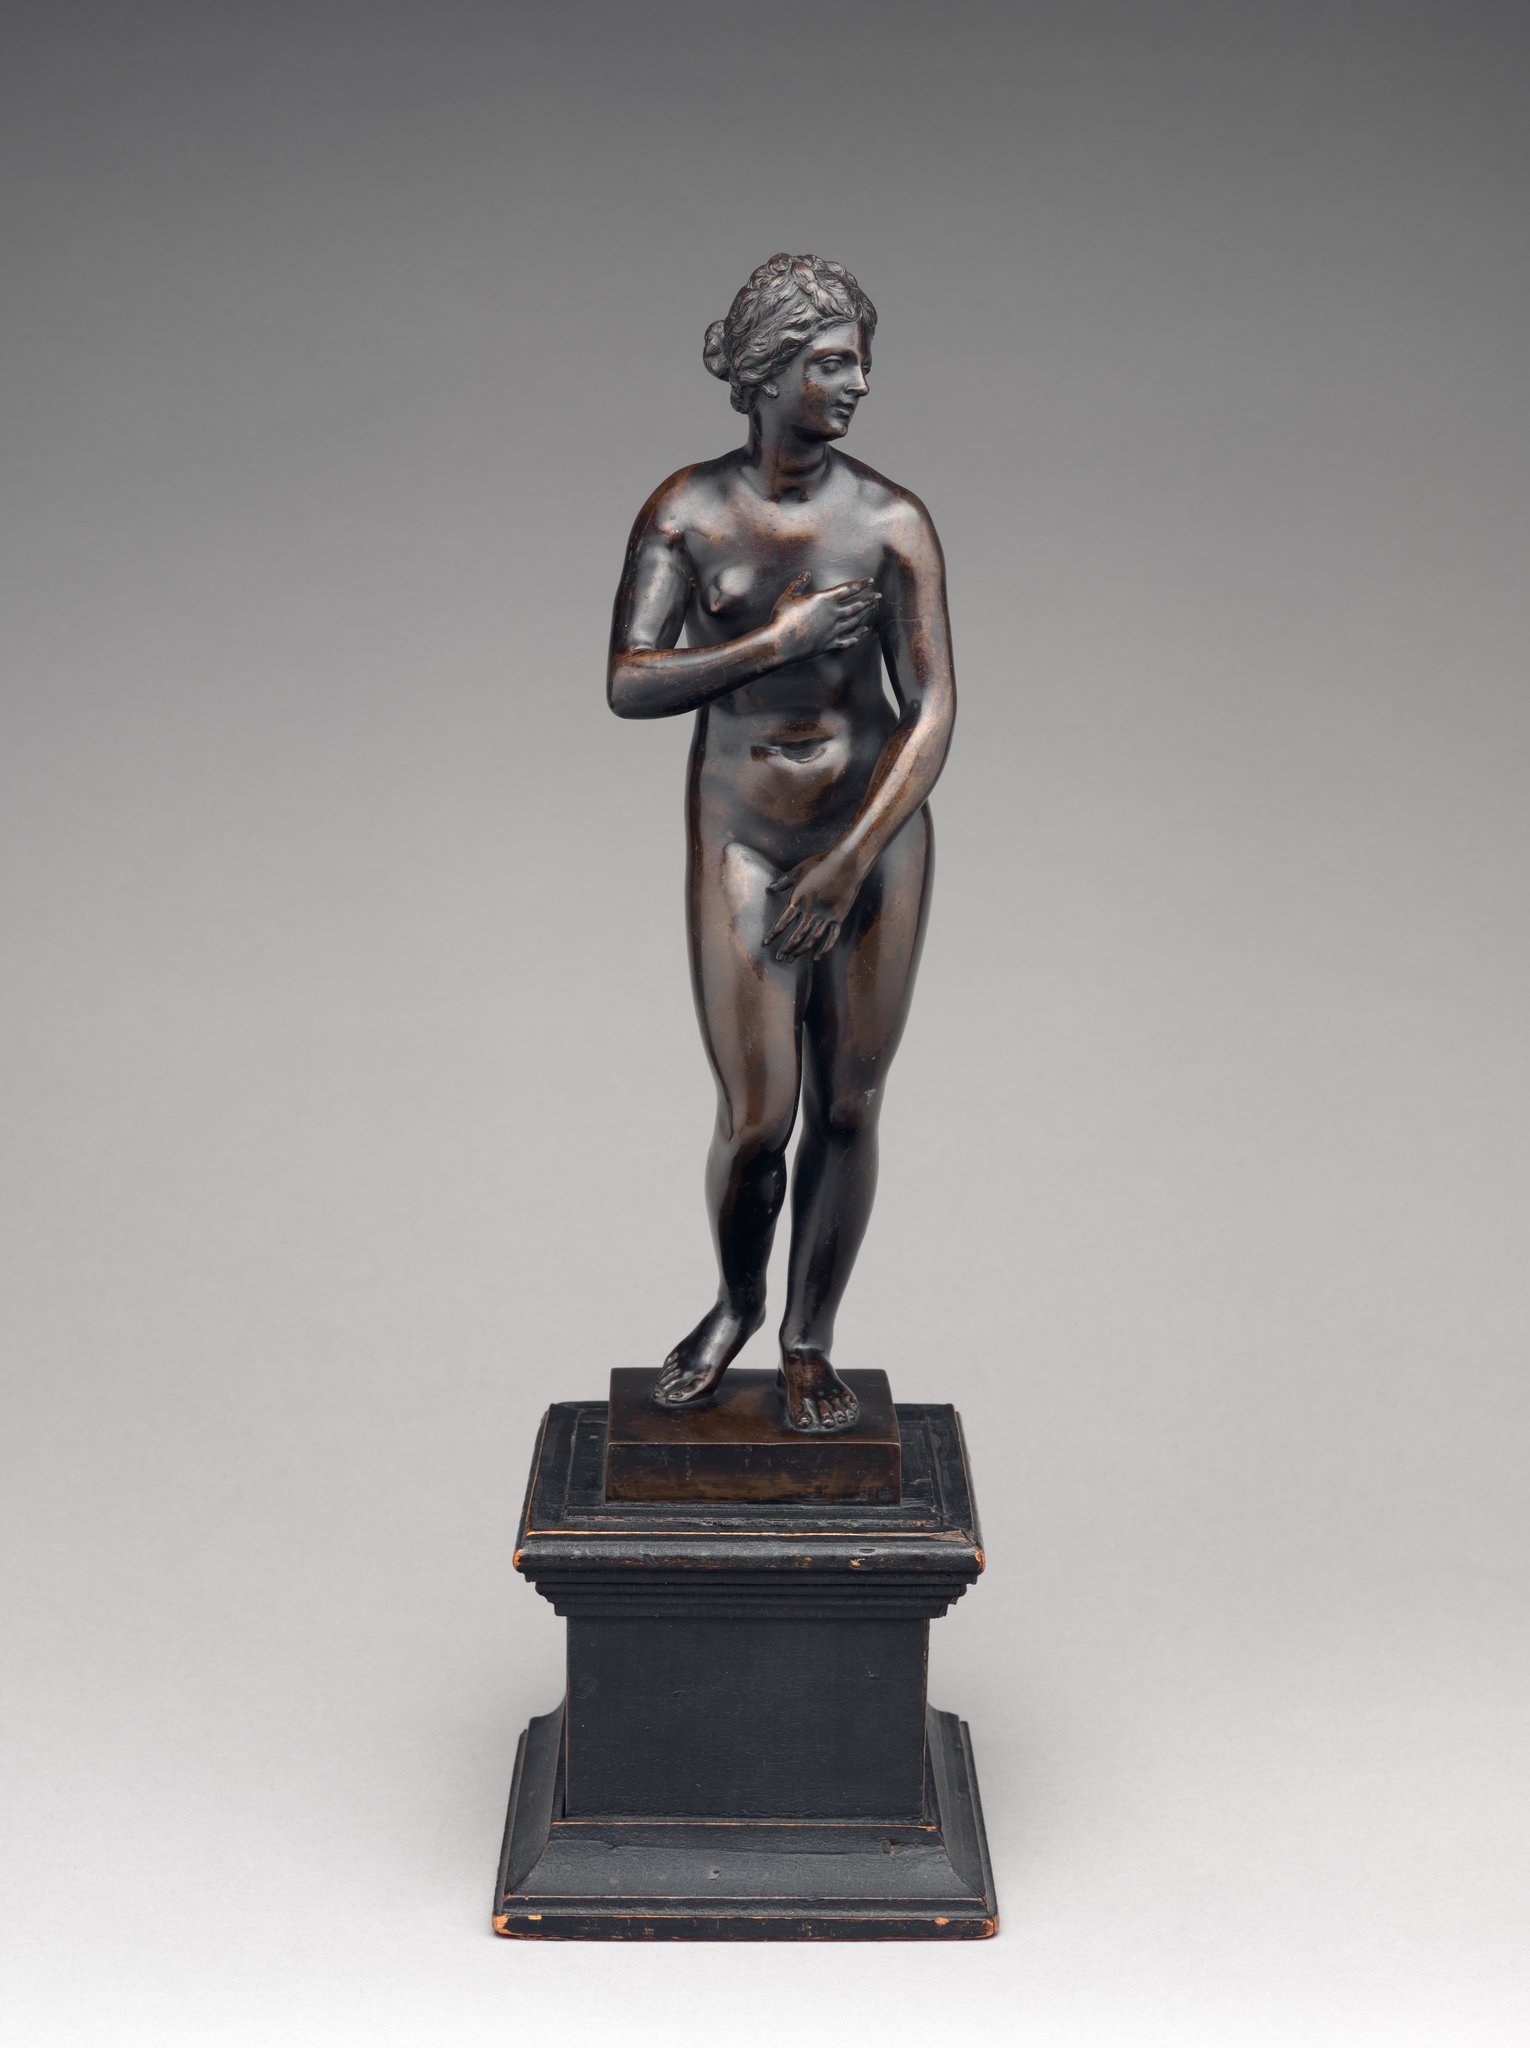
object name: statuette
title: Venus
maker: massimiliano soldani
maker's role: artist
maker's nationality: italian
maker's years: 1656-1740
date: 1701-1800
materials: bronze, wood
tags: venus